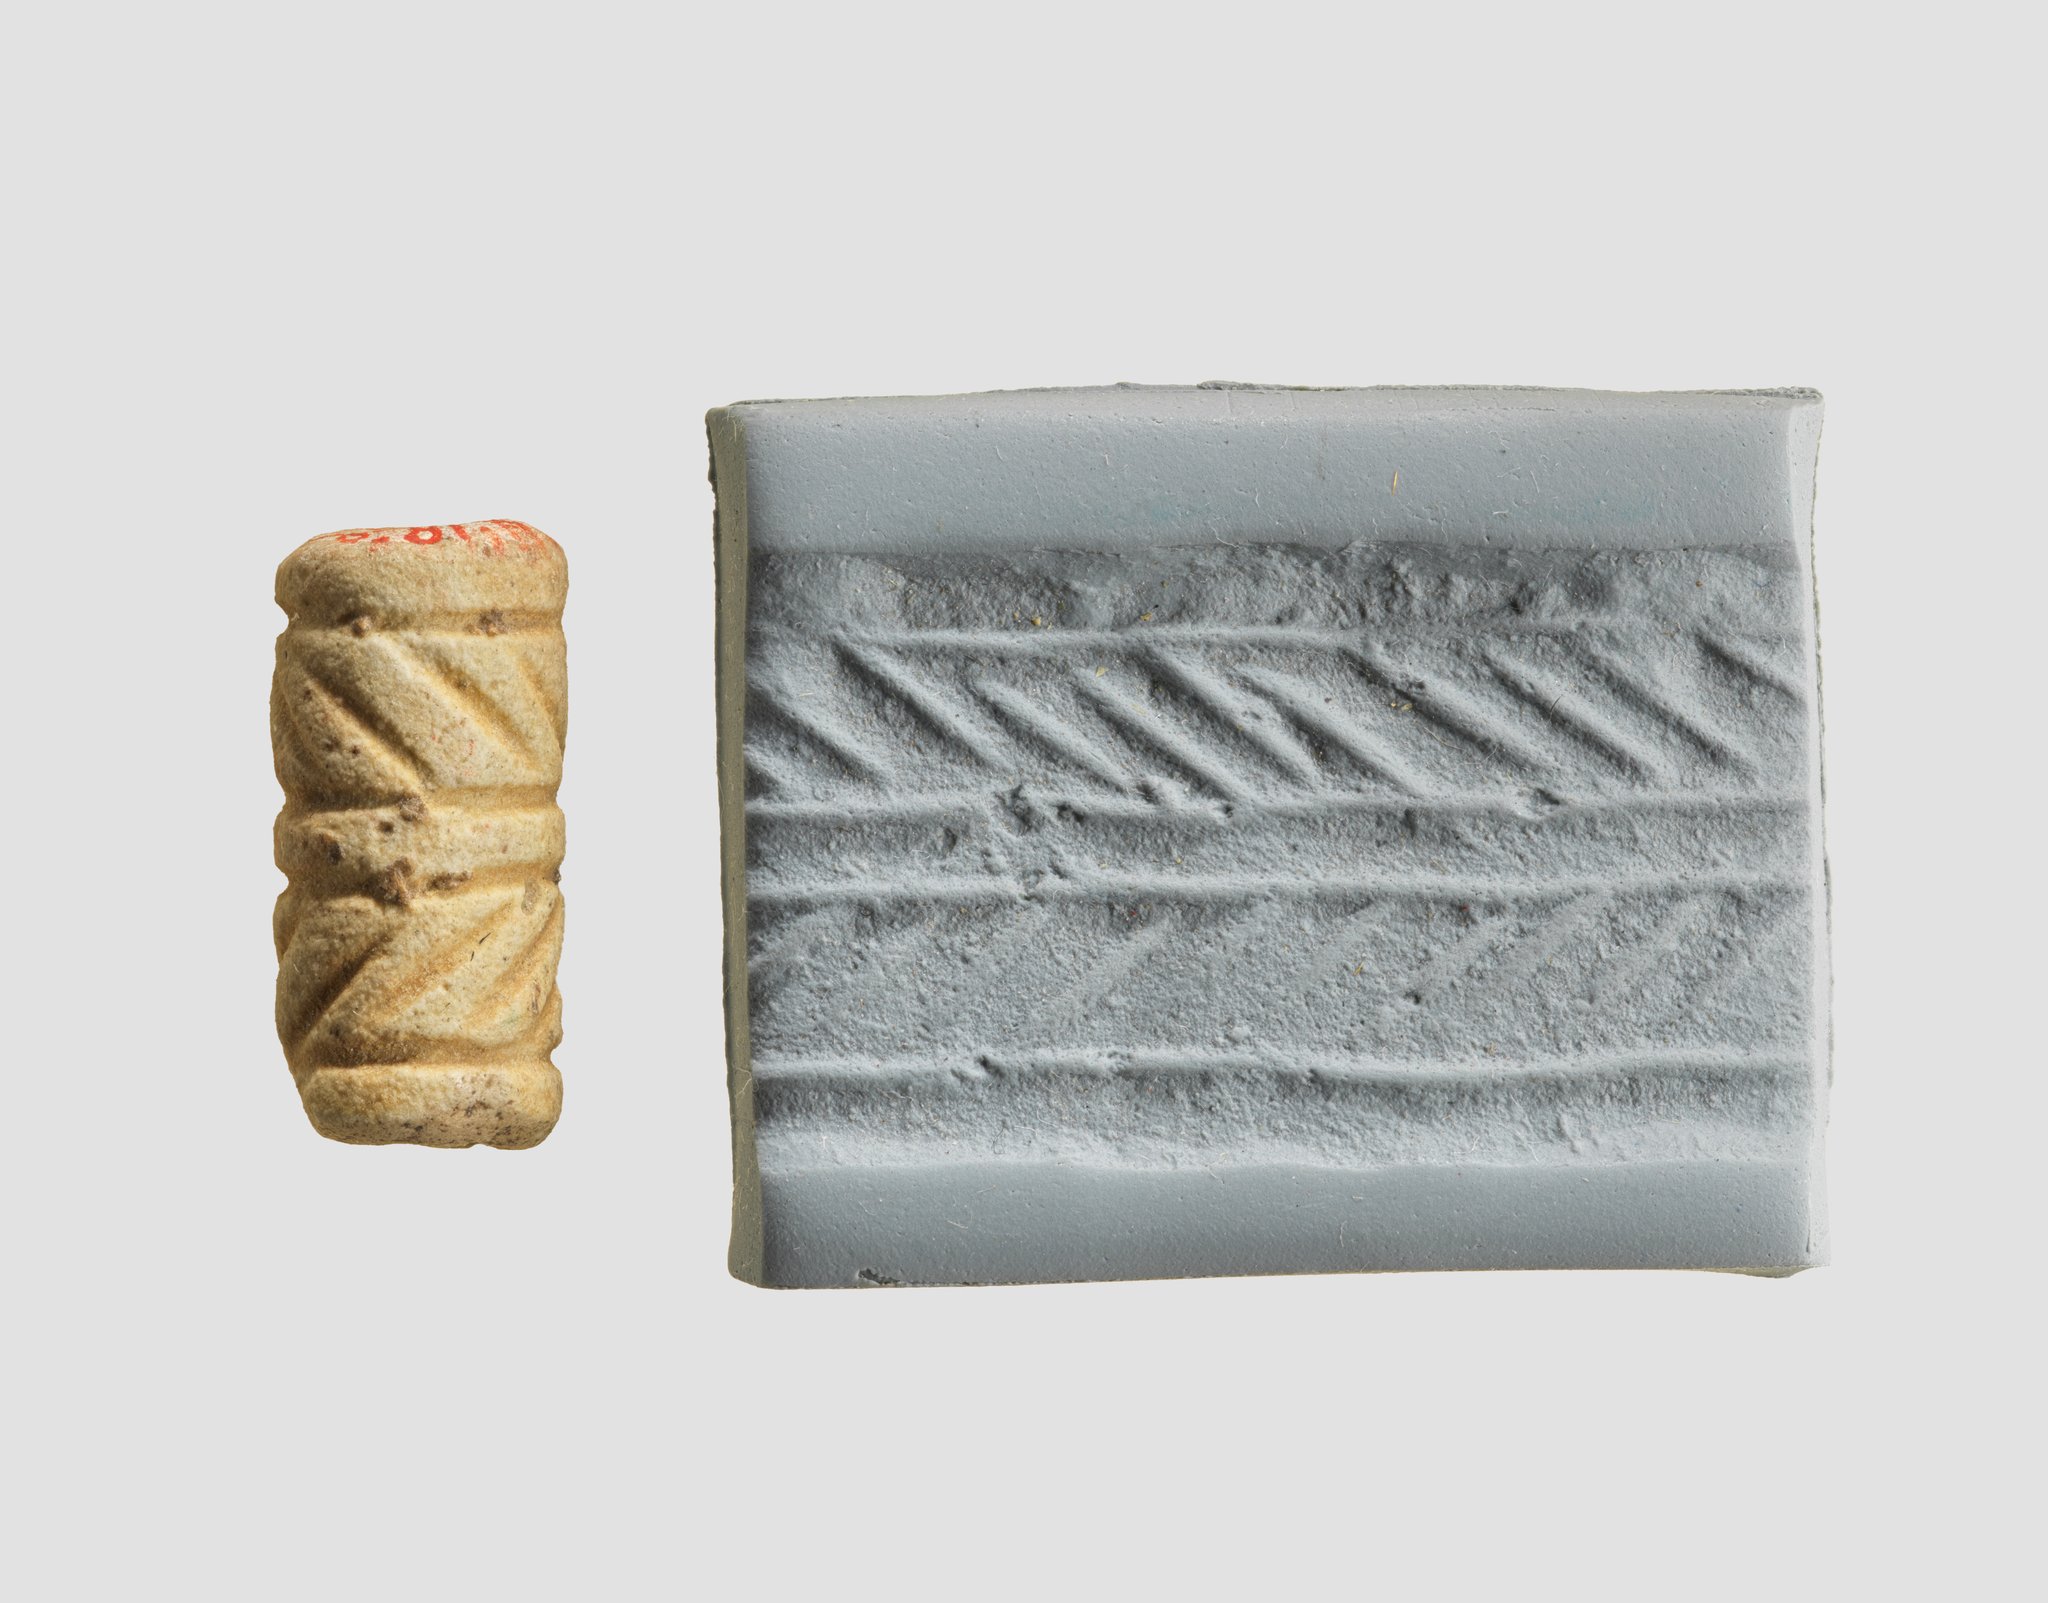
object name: cylinder seal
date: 3100-2900 BCE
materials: faience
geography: mesopotamia or iran